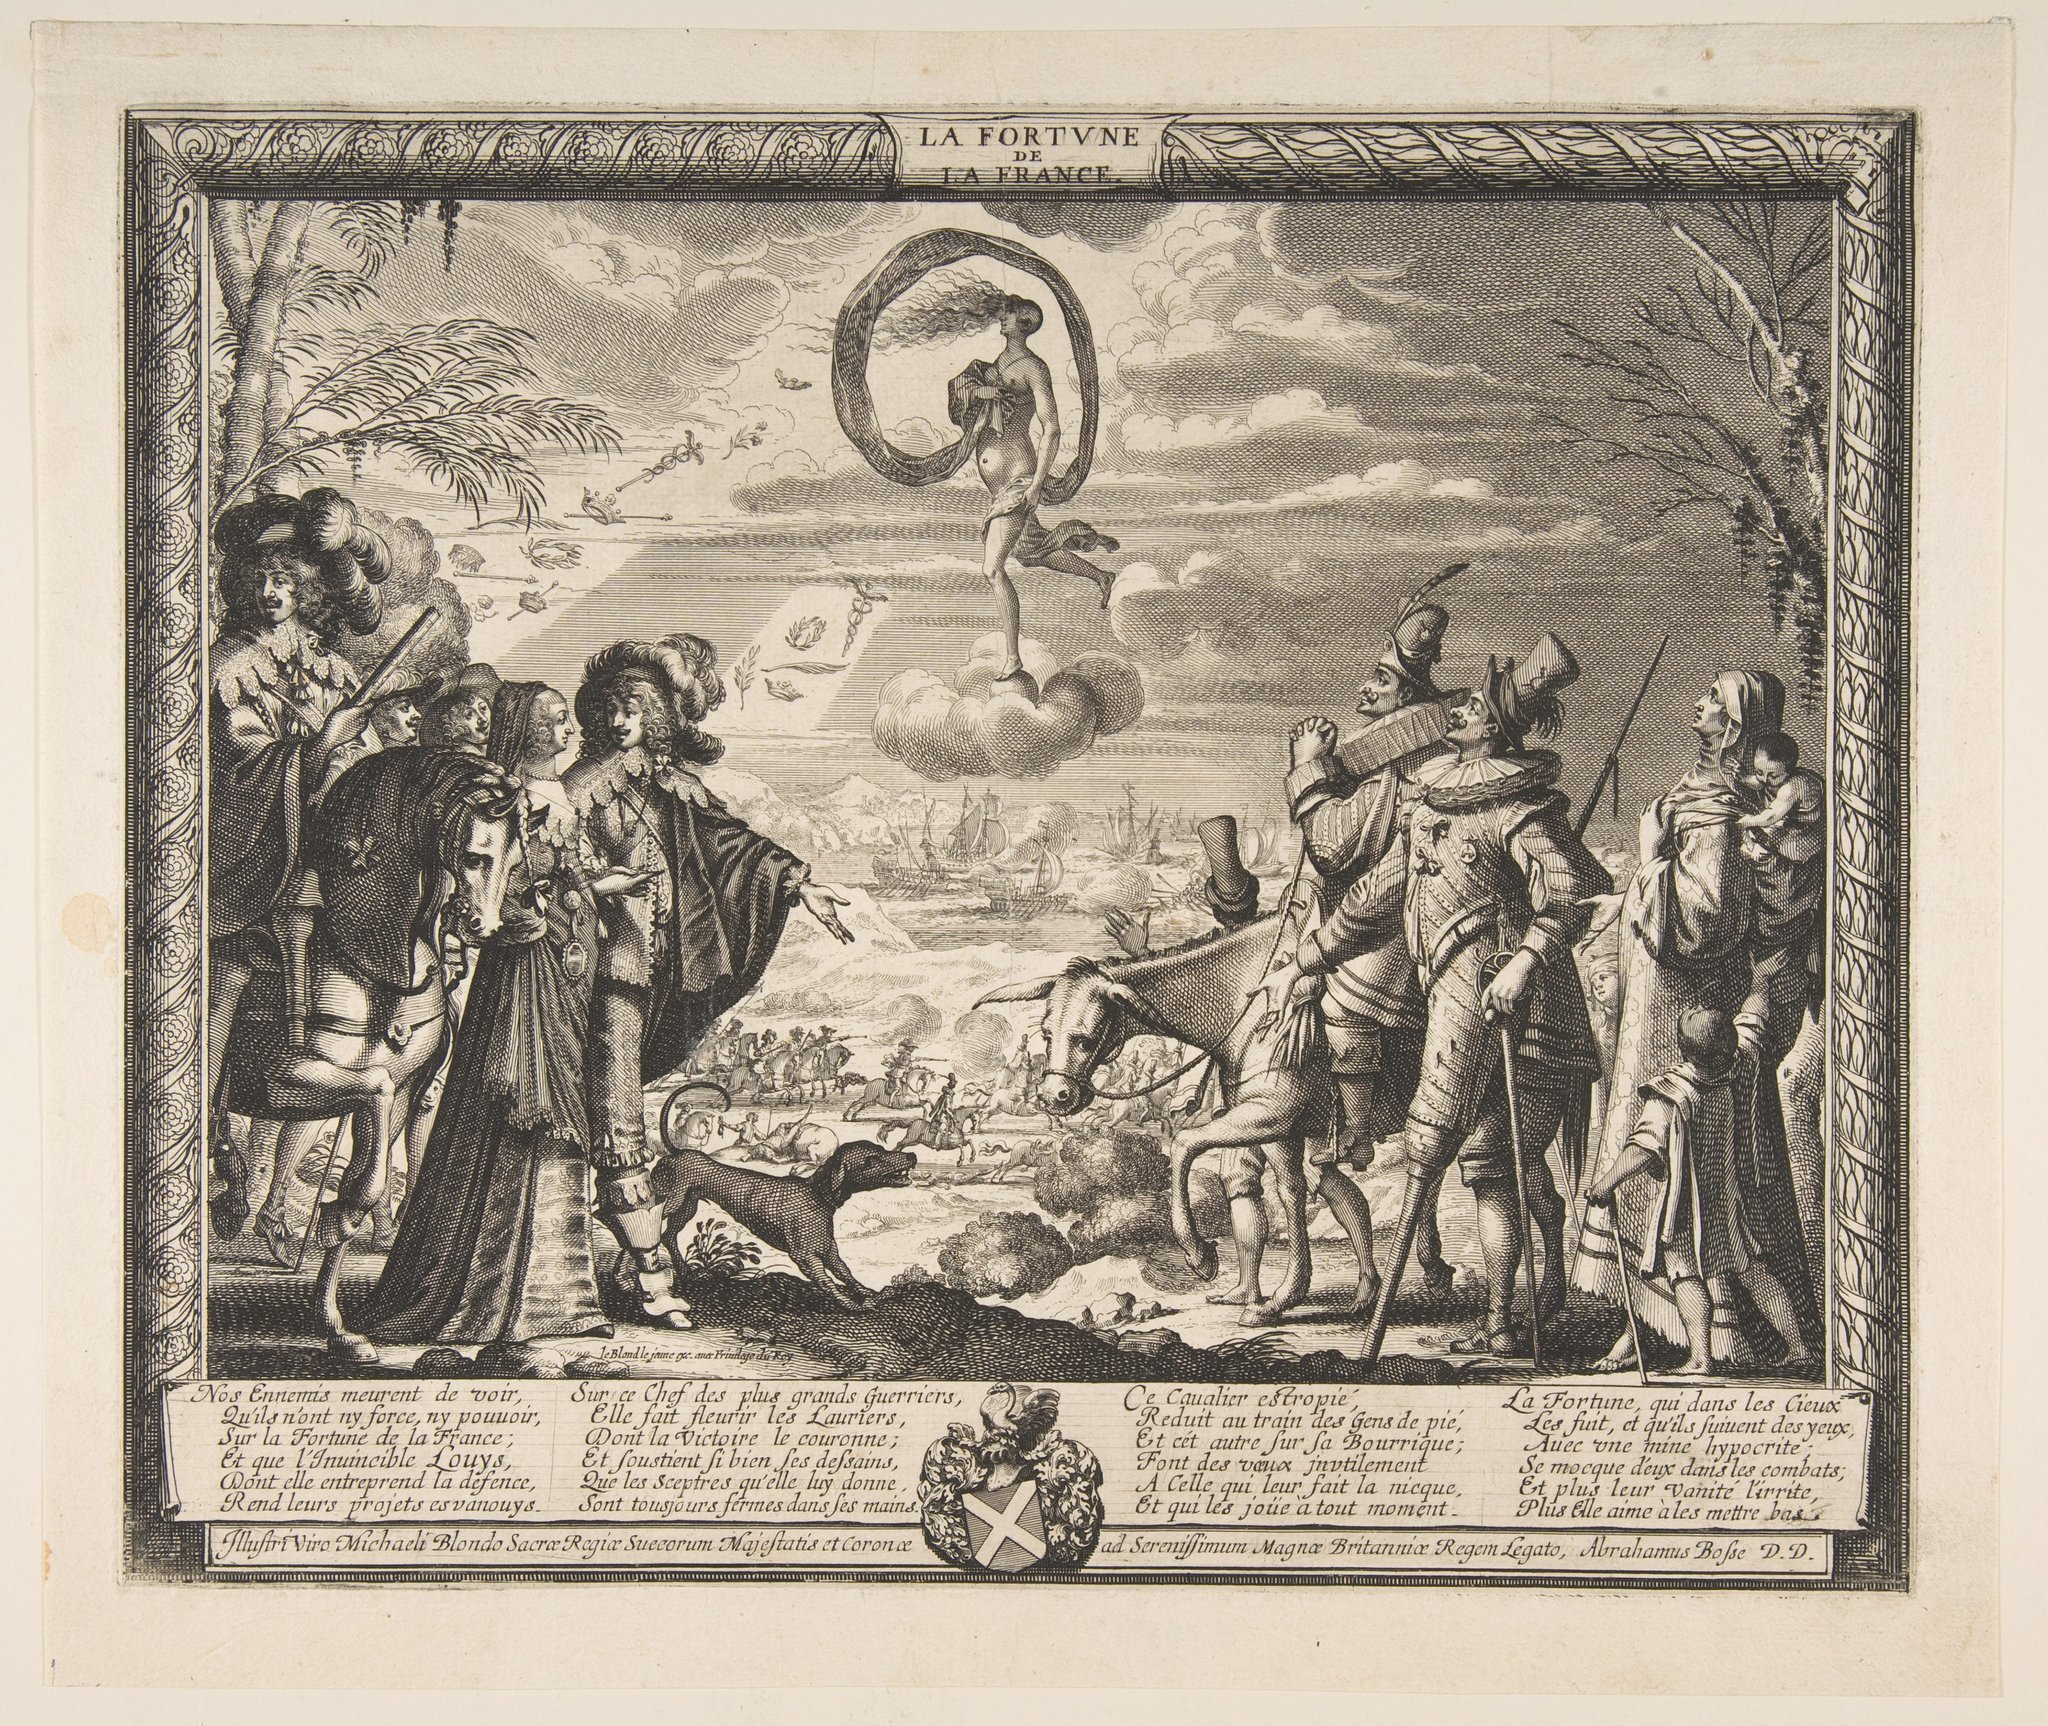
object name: print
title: Fortune Favoring France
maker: abraham bosse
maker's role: artist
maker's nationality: french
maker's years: 1602-1676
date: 1635-1637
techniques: etching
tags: battles,weapons,men,women,dogs,donkeys,horses,coat of arms,ships